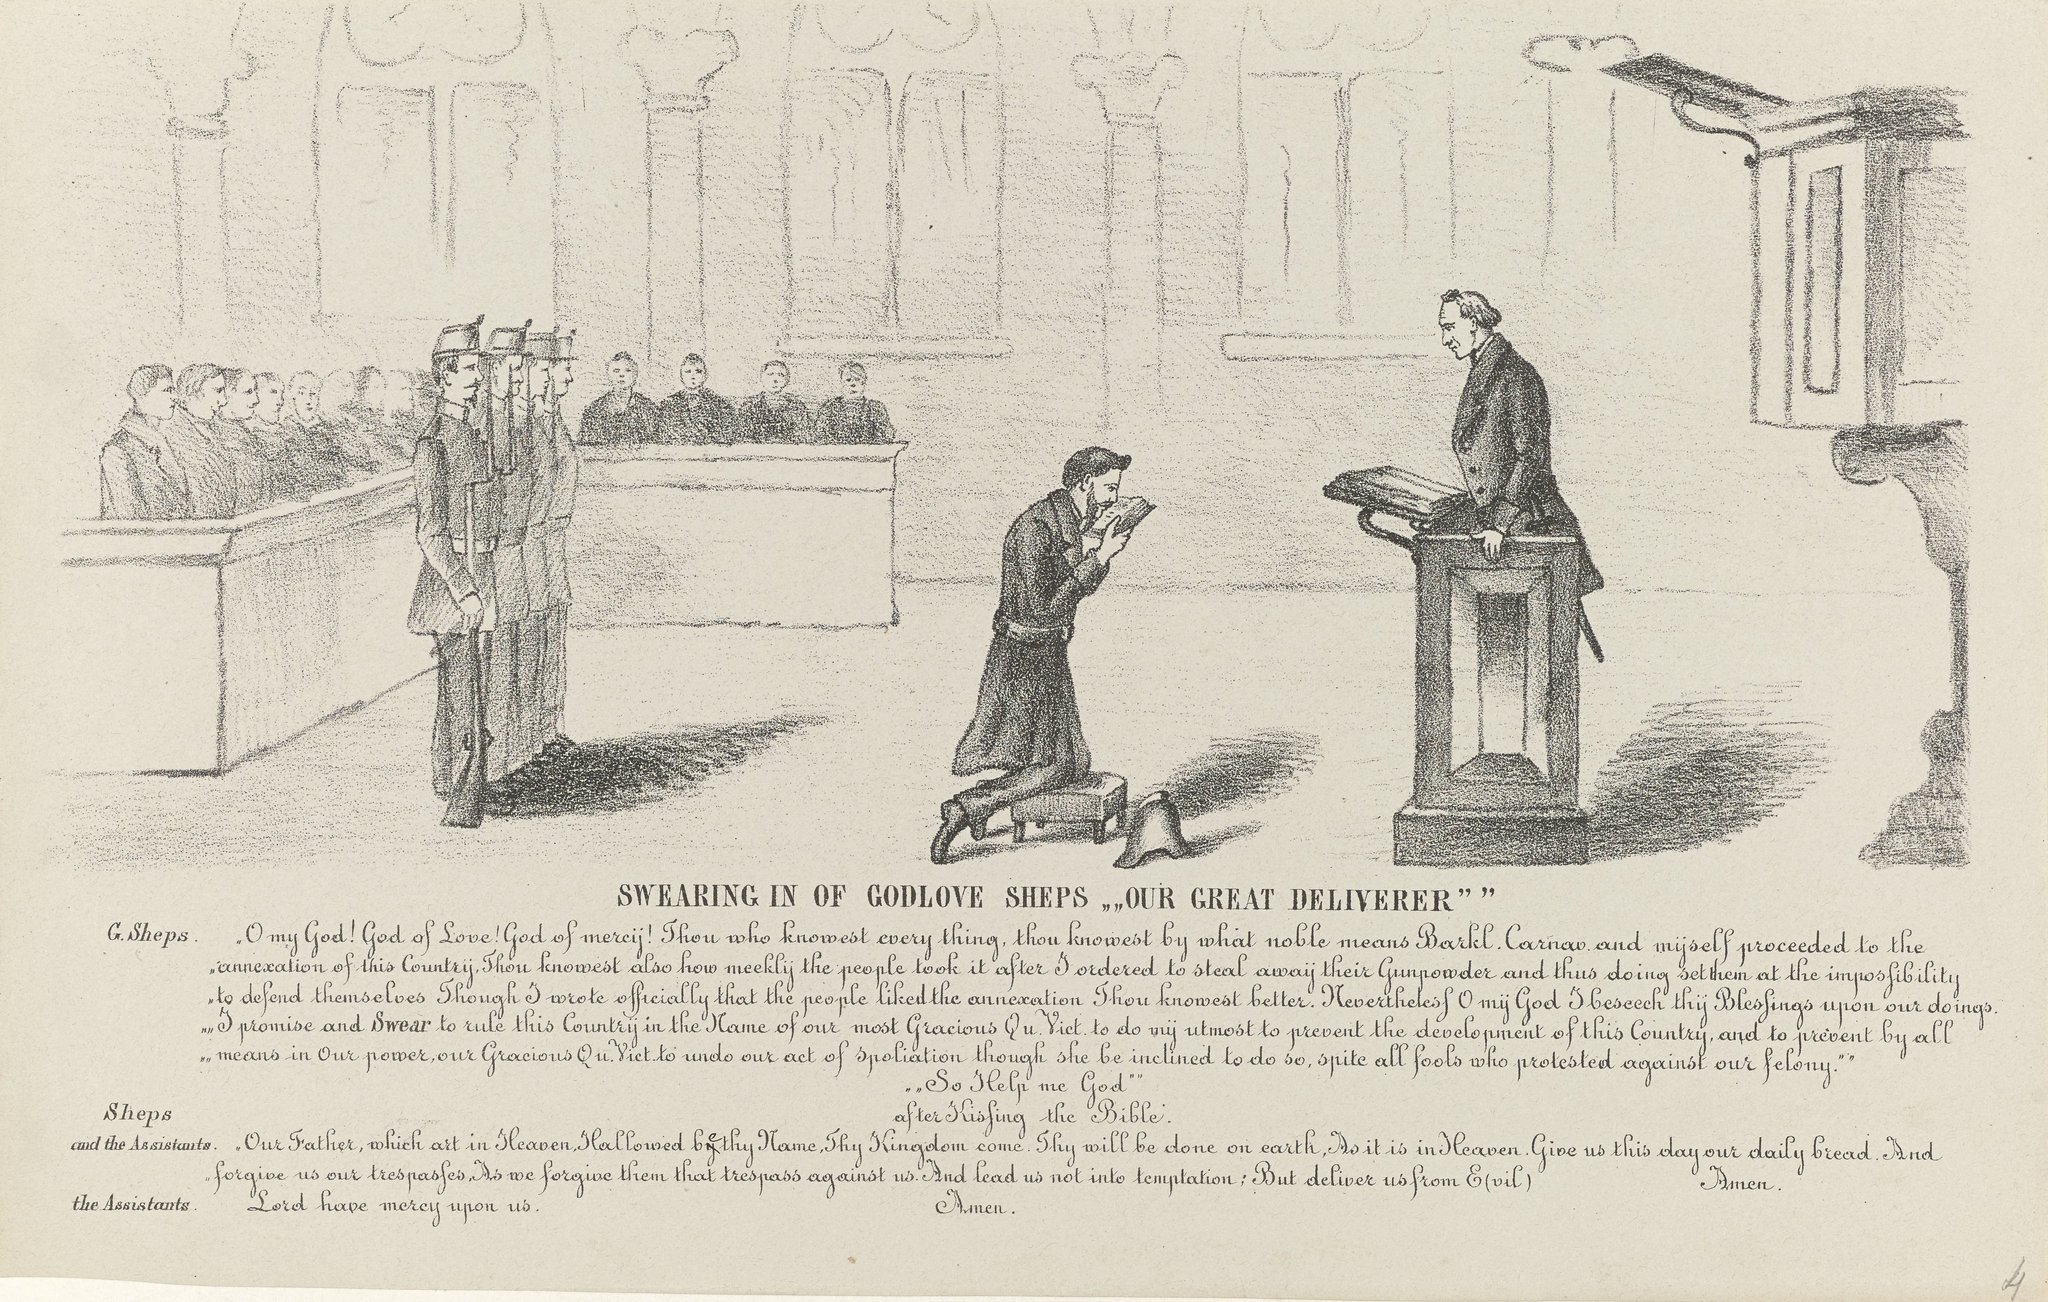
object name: cartoon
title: Swearing in of Godlove Sheps "Our great deliverer"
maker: Anonymous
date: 1877-1880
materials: paper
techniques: lithograph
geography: south africa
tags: swearing an oath (with two fingers raised)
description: Shepstone kust de Bijbel en biecht zijn misdaden op, in een rechtbank of kerk. Met onderschrift. Onderdeel van de serie van elf spotprenten op de Britse annexatie van Transvaal in 1877.